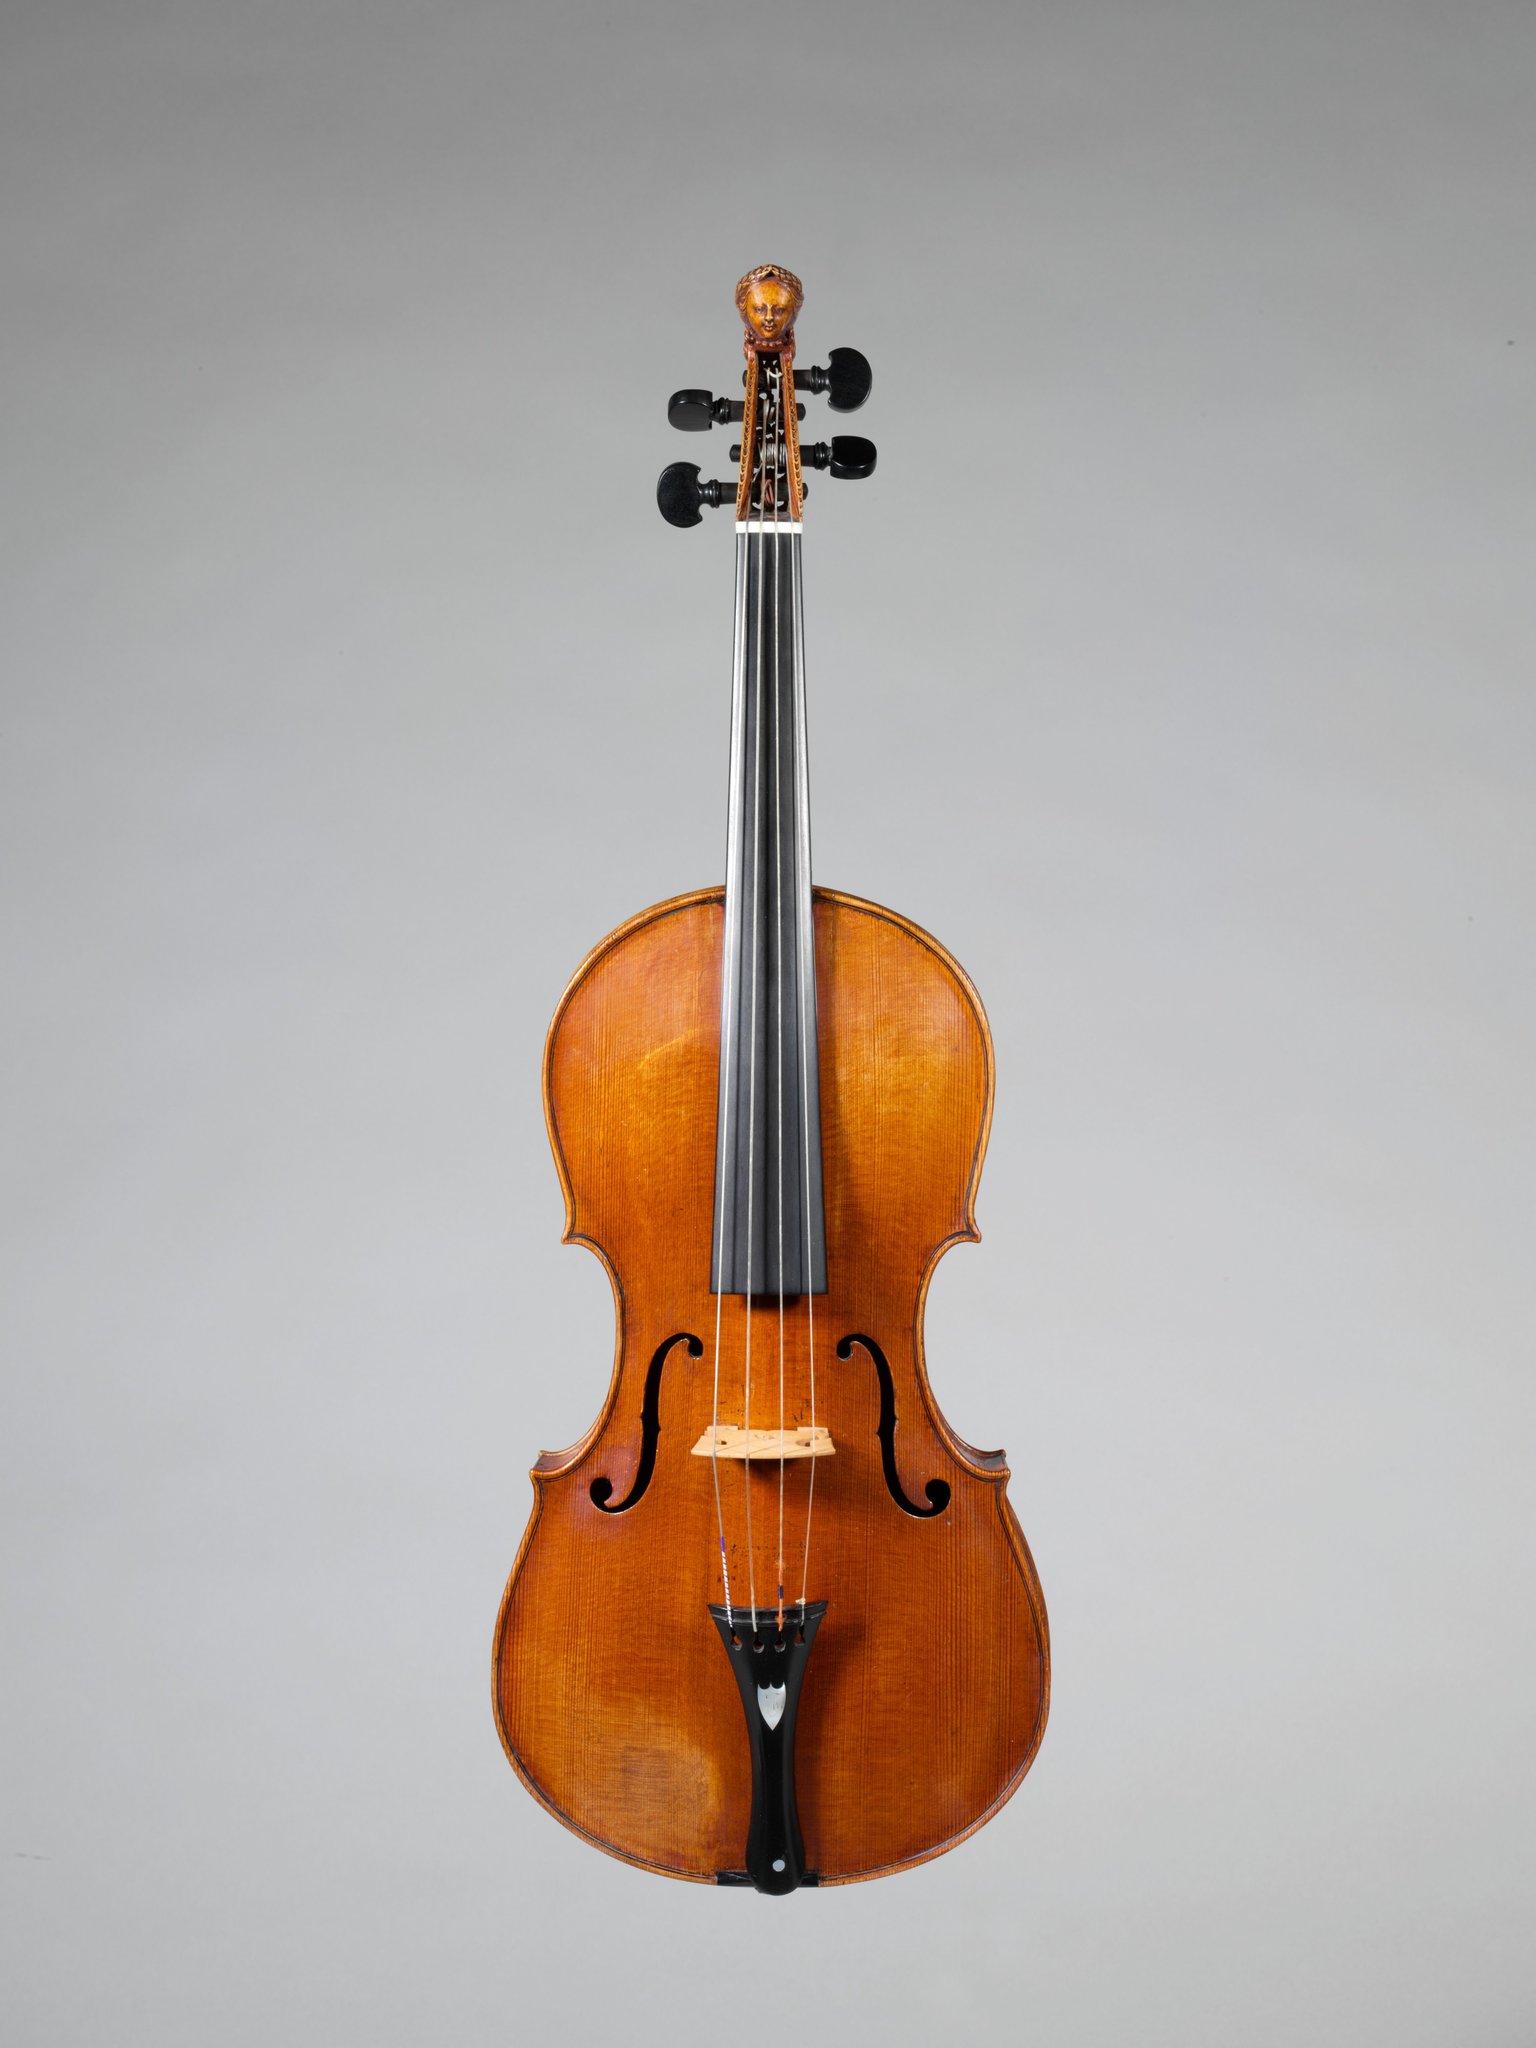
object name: violin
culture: german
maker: joachim tielke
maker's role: maker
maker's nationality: german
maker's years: 1641-1719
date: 1685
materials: wood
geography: germany